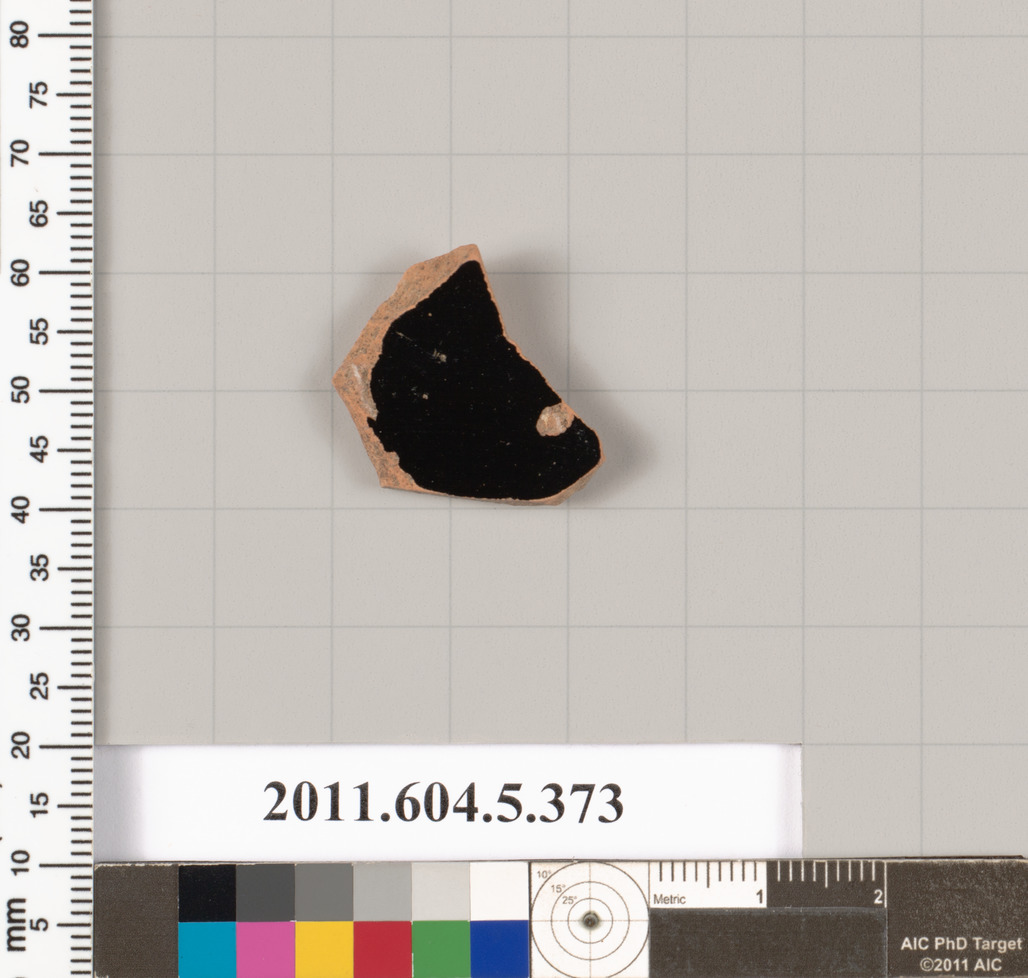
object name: kylix fragment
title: Terracotta fragment of a kylix (drinking cup)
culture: greek, attic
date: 600-401 BCE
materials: terracotta